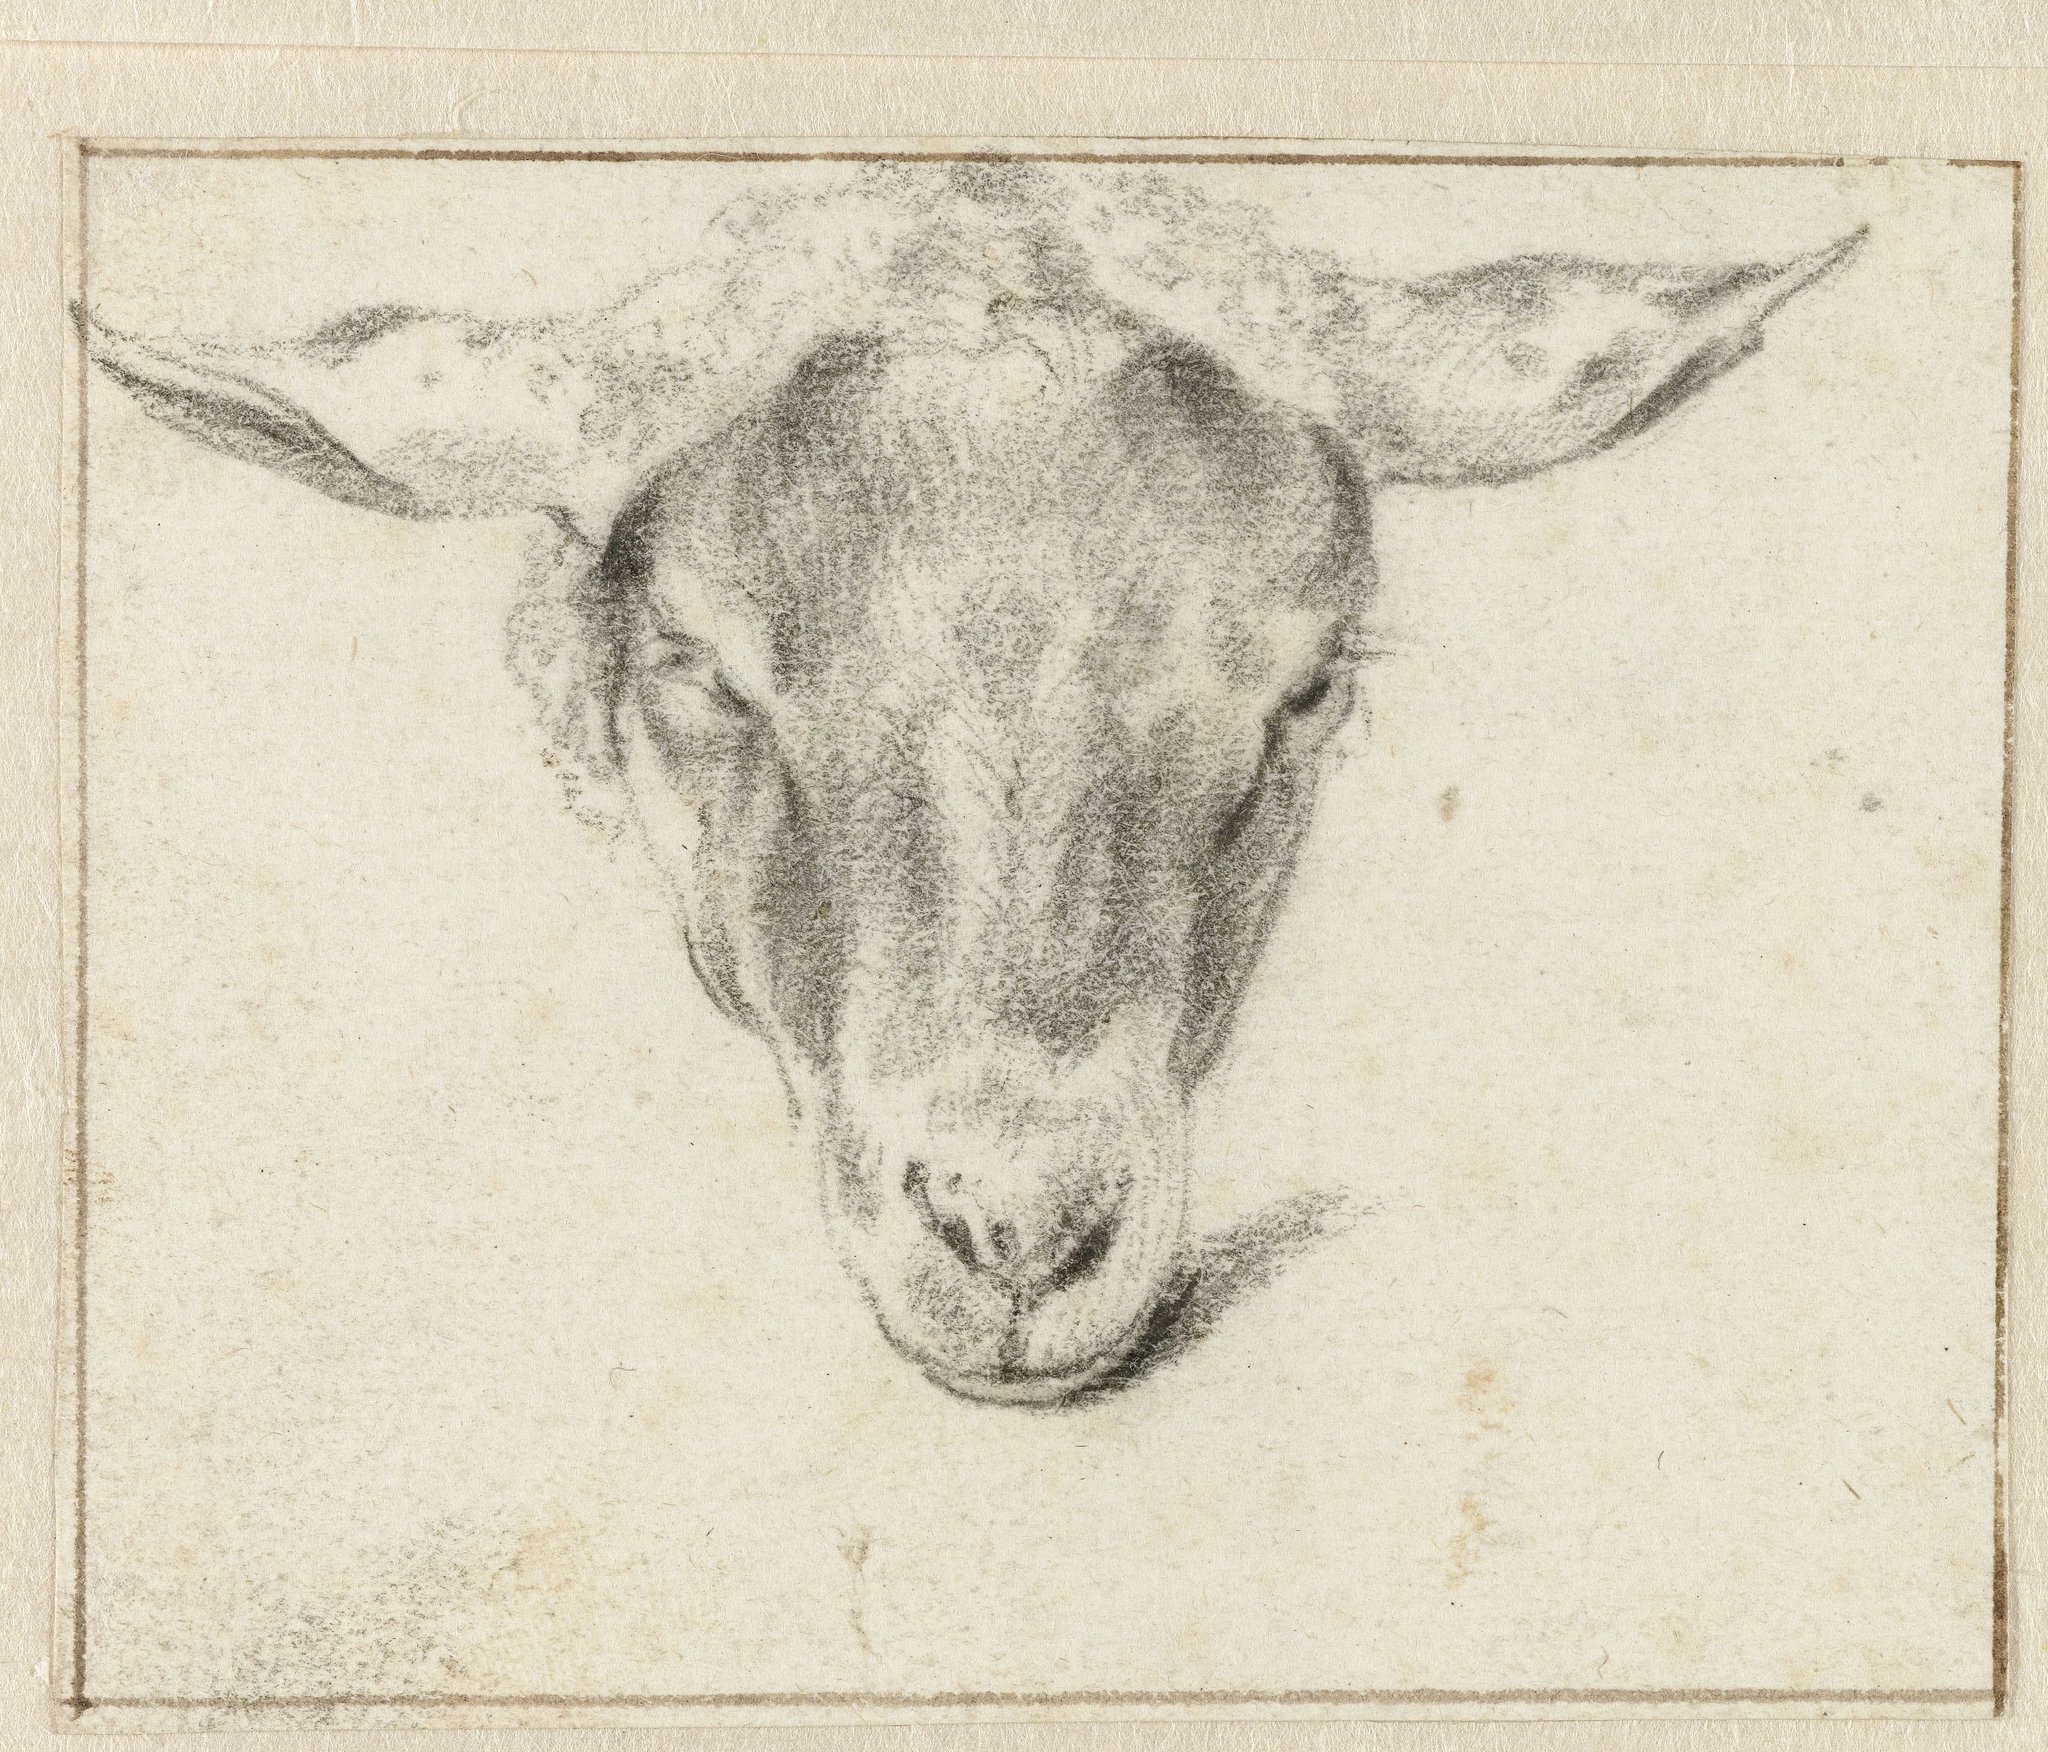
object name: drawing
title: Schapenkop, van voren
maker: adriaen van de velde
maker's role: draughtsman, painter, print maker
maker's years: 1636-1672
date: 1646-1672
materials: chalk, paper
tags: sheep (+ head of an animal)